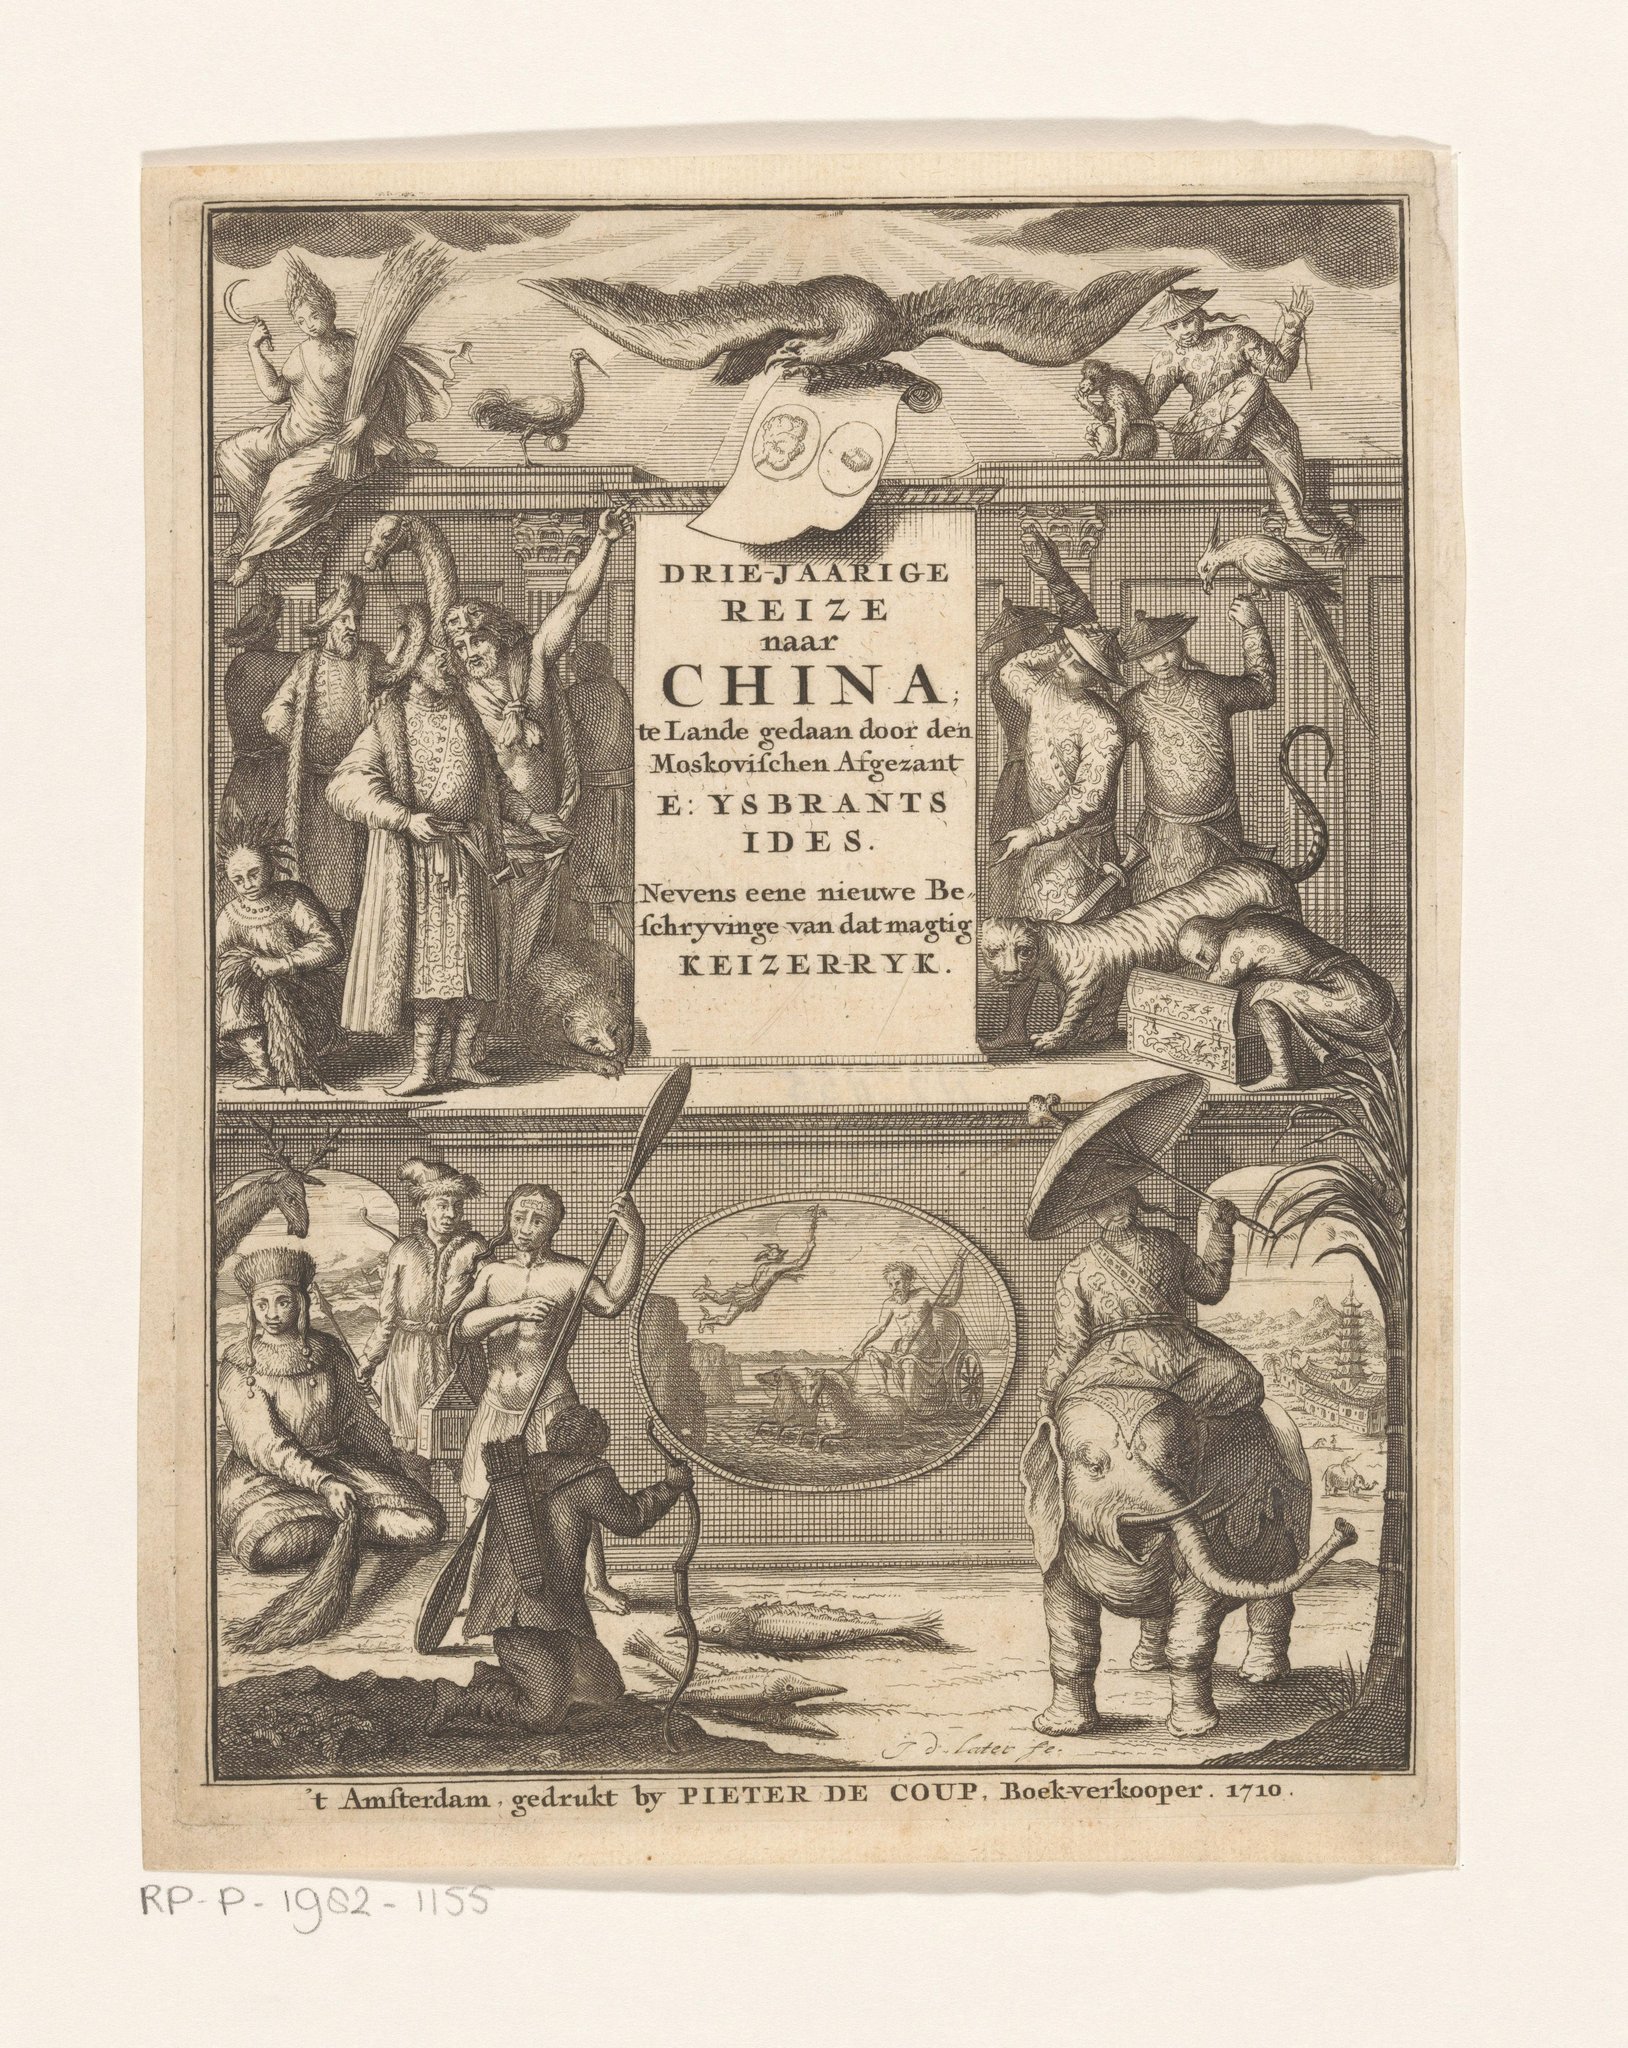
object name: print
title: Europese reizigers en inwoners van de door hen bezochte landen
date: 1710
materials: paper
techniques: engraving, etching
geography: amsterdam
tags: chinese, travelling; tourism, europeans (with name)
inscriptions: collector's mark: Lugt 2228, collector's mark: Lugt 2760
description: Een architecturale setting met in het midden de titel van het boekwerk. Links staan Europese reizigers vergezeld door Hercules en een figuur met verentooi. Boven hen zit Ceres met sikkel en korenschoof. Rechts staan Chinezen met een vogel en tijger. Boven hen een zittende Chinees met een aap aan een touw. Midden boven een adelaar met een vel papier in zijn klauwen. Aan de onderzijde links figuren van verschillende afkomst met bontmuts, een rok van veren, een peddel en pijl en boog. Aan de onderzijde rechts een Chinees met parasol rijdend op een olifant. Midden onder een medaillon met Neptunus en Mercurius.